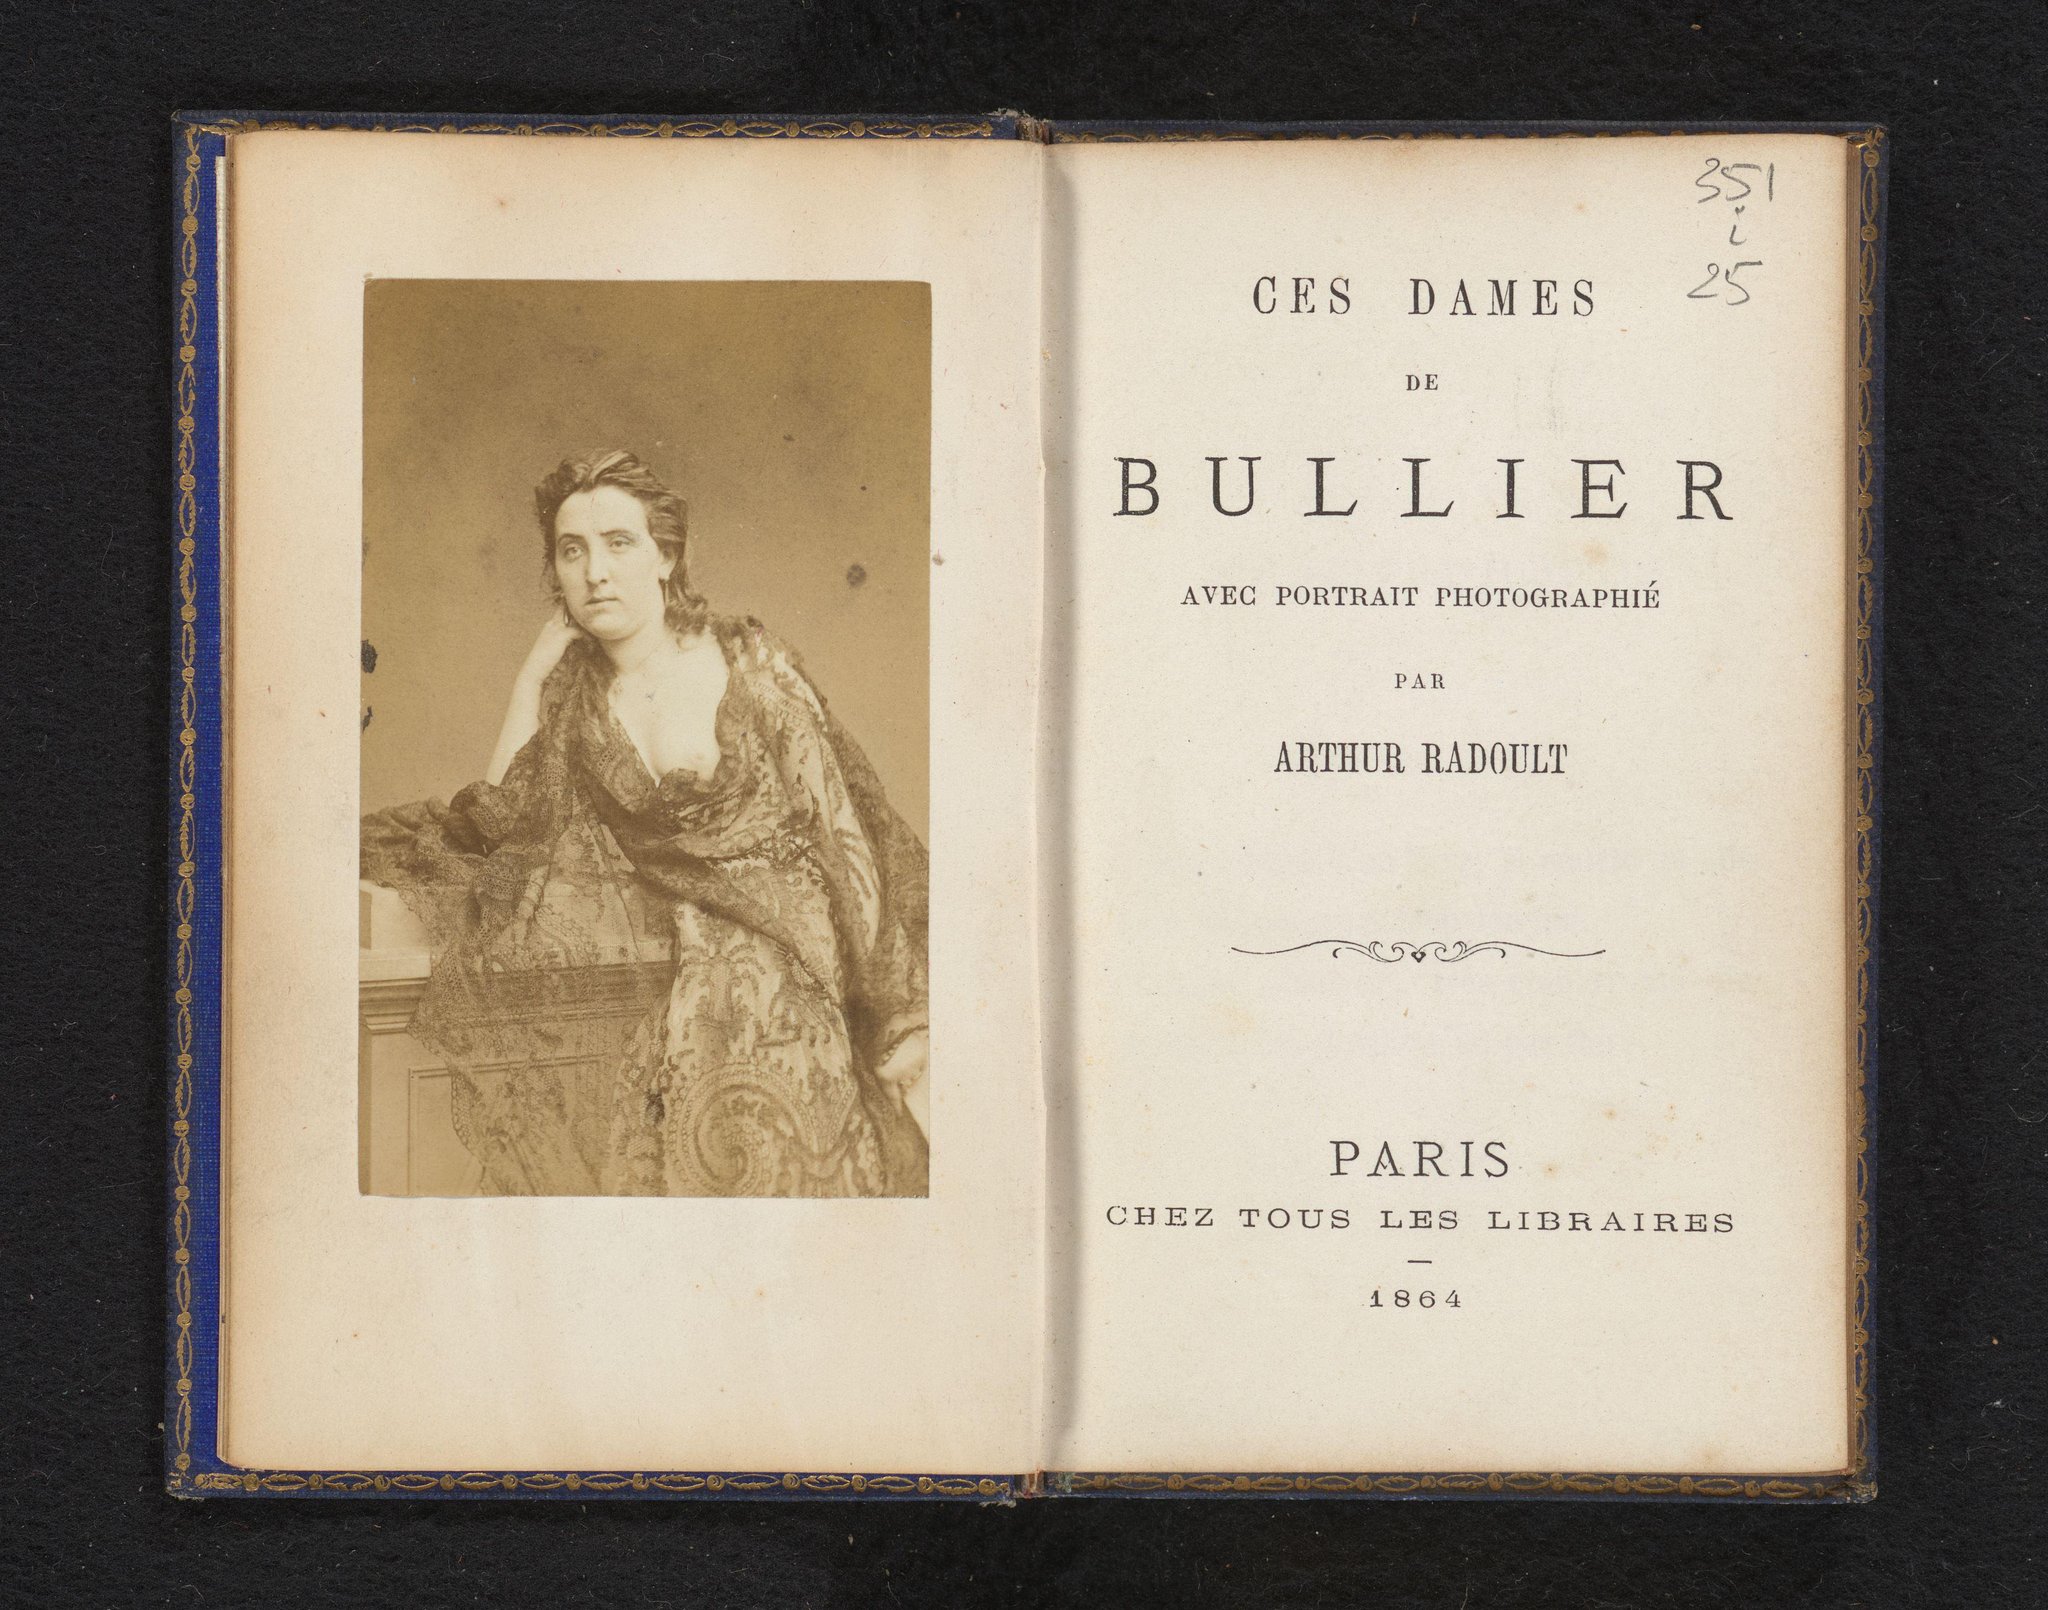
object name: photograph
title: Portret van een onbekende vrouw in negligé, mogelijk een actrice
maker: arthur radoult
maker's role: fotograaf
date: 1859-1864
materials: paper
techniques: albumen print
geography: paris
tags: historical persons not known by name - bb - woman, woman (showing herself) undressed, quasi-nude, portrait of actor, actress